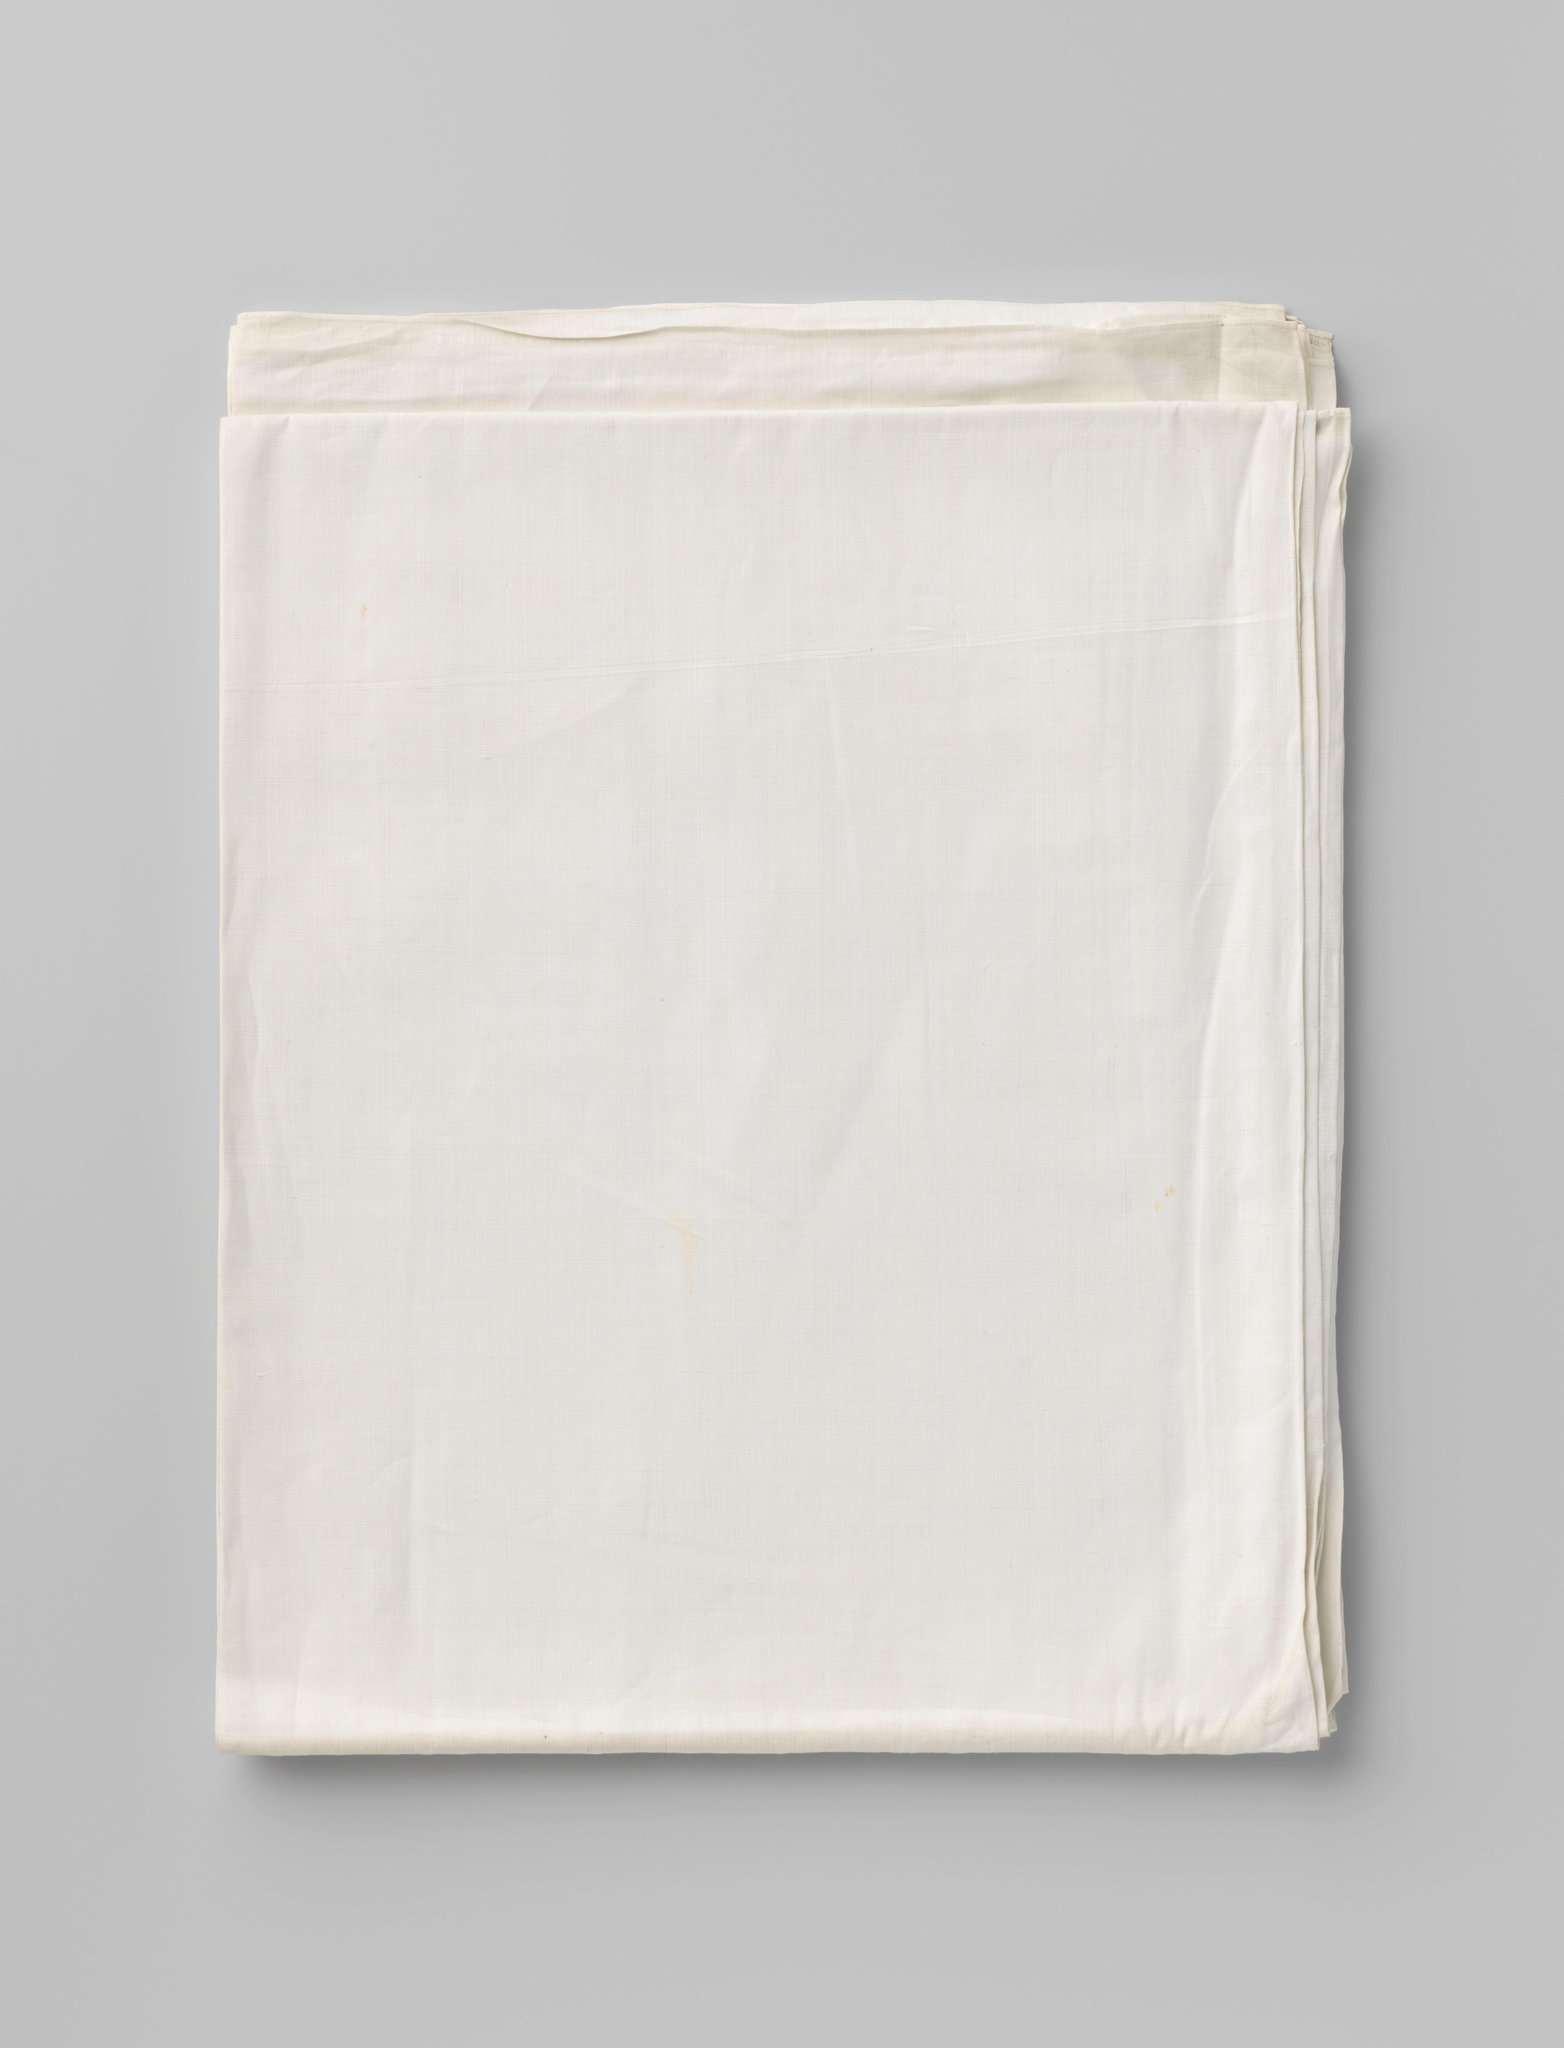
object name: beddenlaken, laken object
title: Laken.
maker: Anonymous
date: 1650-1700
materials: linen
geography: northern netherlands